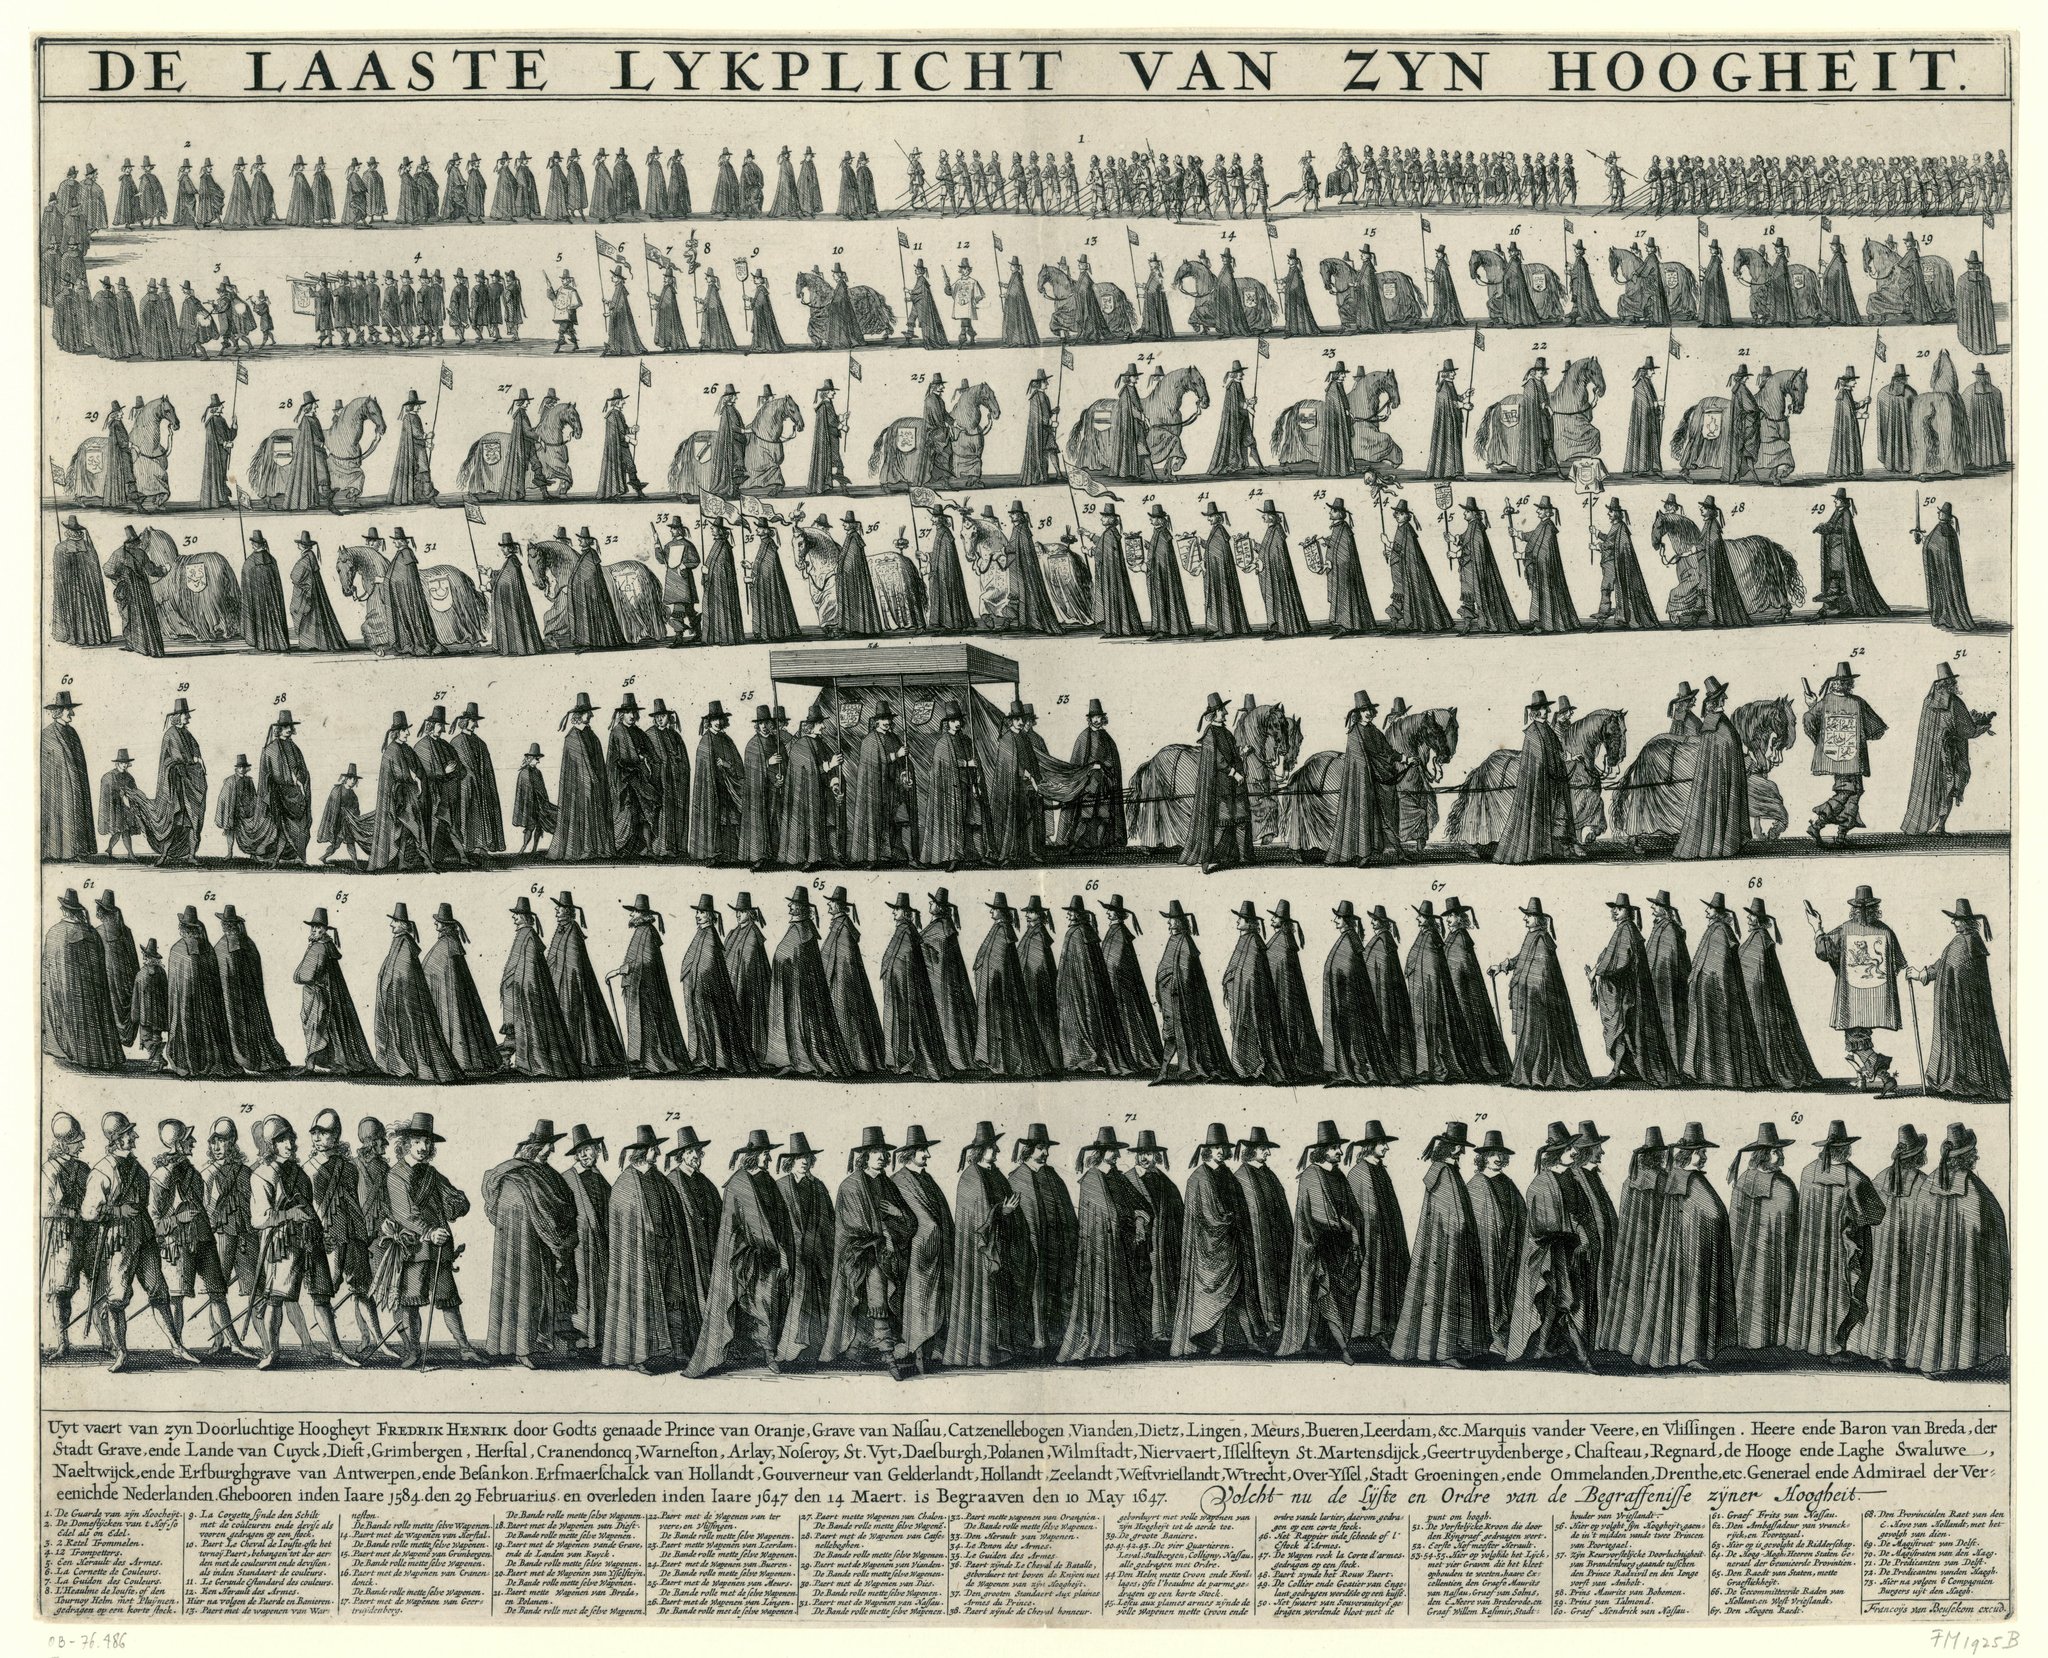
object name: print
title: De Laaste Lykplicht van Zyn Hoogheit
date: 1647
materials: paper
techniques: etching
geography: amsterdam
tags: delft, the hague, frederick henry (prince of orange), cortege, funeral procession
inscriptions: collector's mark: Lugt 963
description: De begrafenisoptocht met de kist met het lichaam van Frederik Hendrik in zeven rijen. Lijkstatie gehouden op 10 mei 1647 te 's-Gravenhage. Onder de voorstelling staat de legenda met de namen van de deelnemers aan de stoet genummerd 1-73. Boven de legenda een onderschrift van 4 regels in het Nederlands met alle titels van de overleden prins.